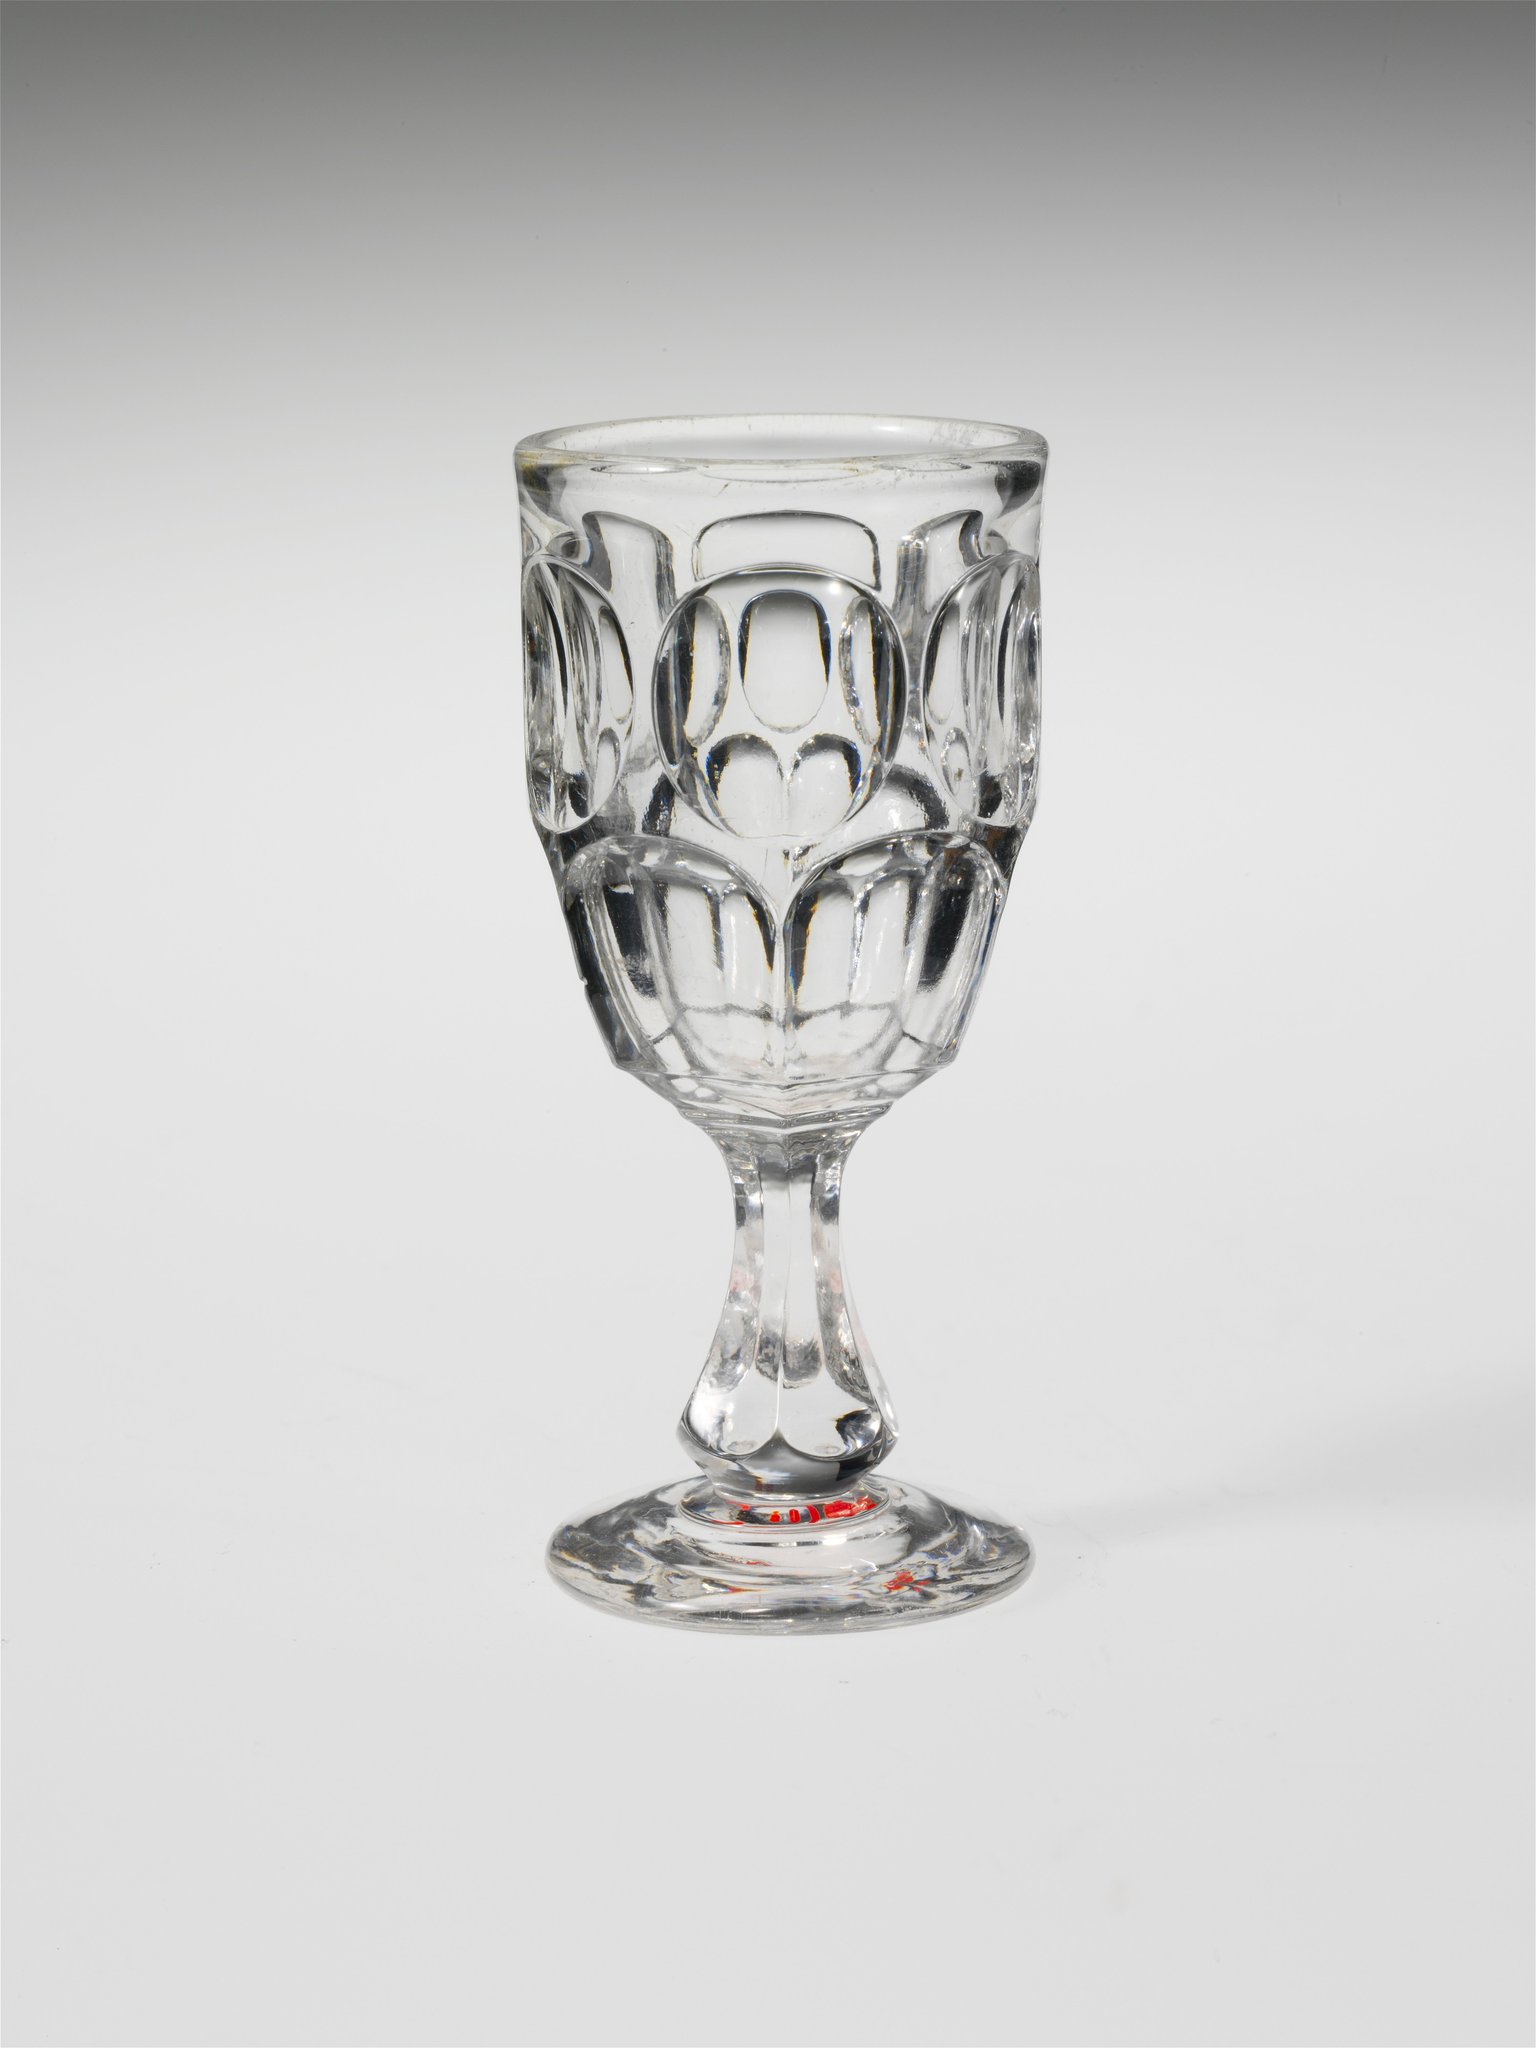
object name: cordial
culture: american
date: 1830-1870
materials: glass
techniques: pressed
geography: united states